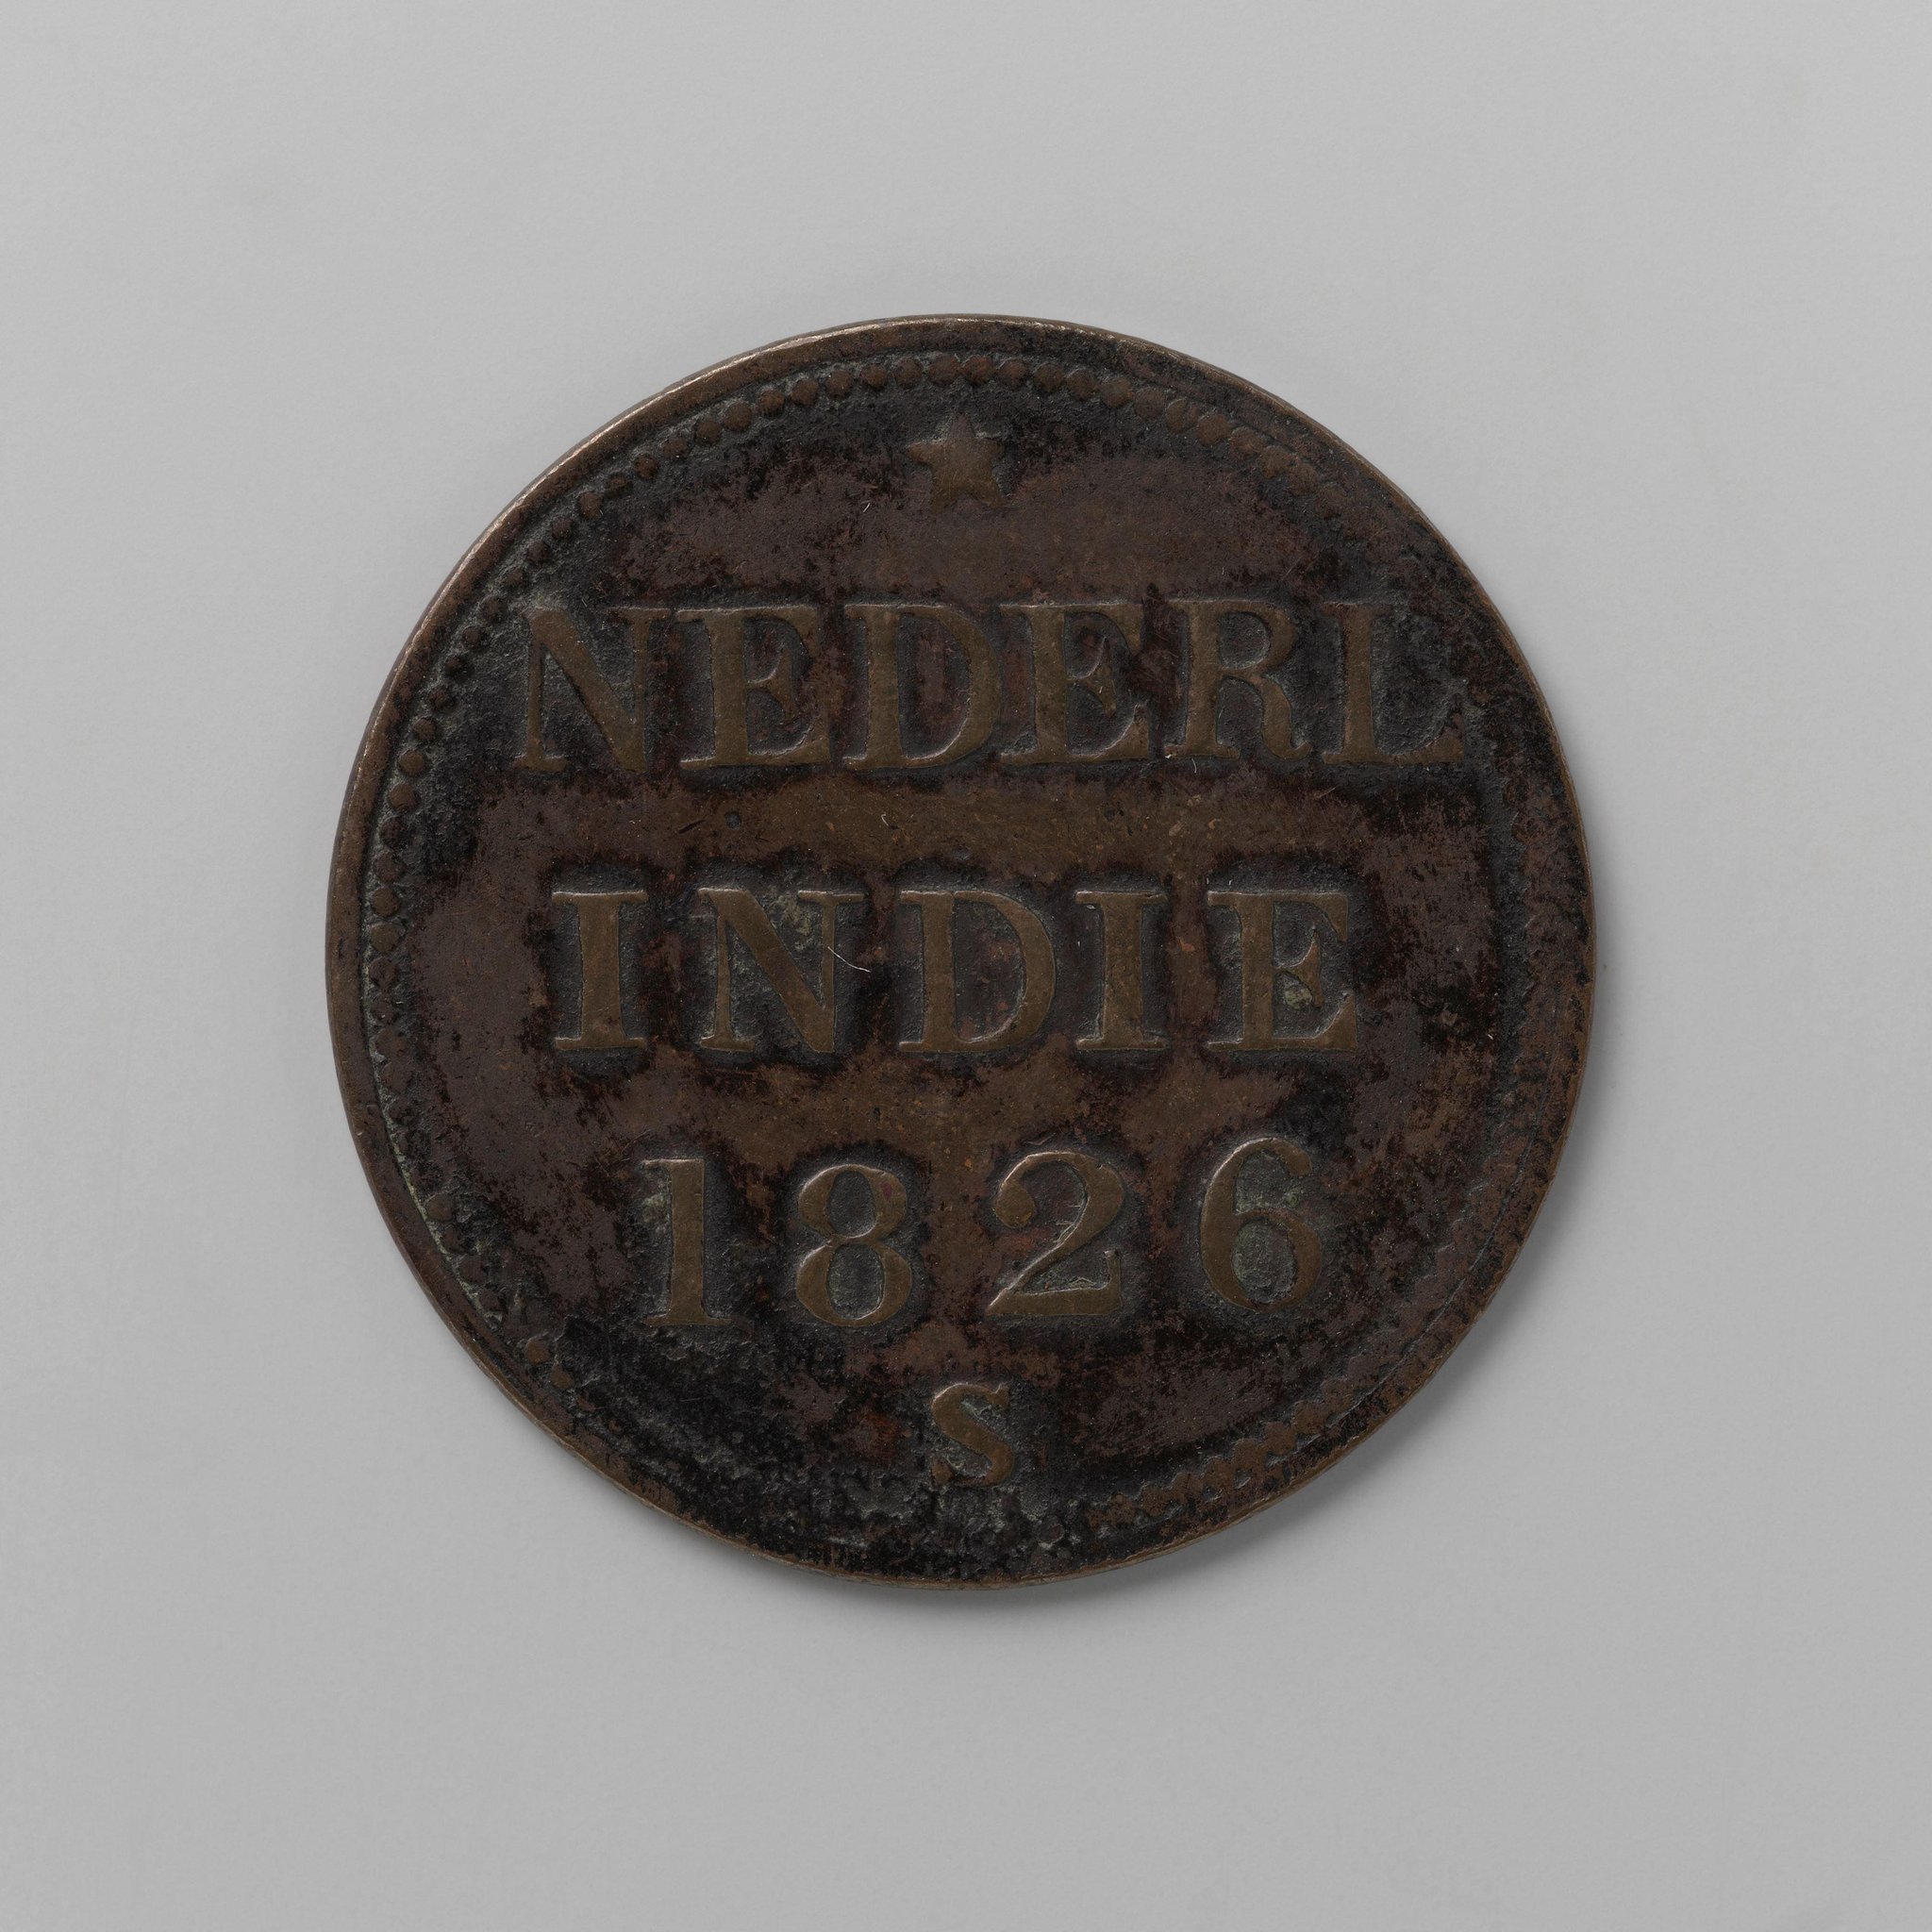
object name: coin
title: Nederlands Indië,1/4 stuiver,1826. Engelse vervalsing en incusum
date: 1826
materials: copper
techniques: striking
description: Koperen munt. Voorzijde: incusum van de keerzijde. Keerzijde: tweeregelig opschrift, waarboven muntteken en waaronder jaartal. Daaronder letter S. Beide keerzijden versierd met partelrand. Gladde rand. Engelse vervalsing.